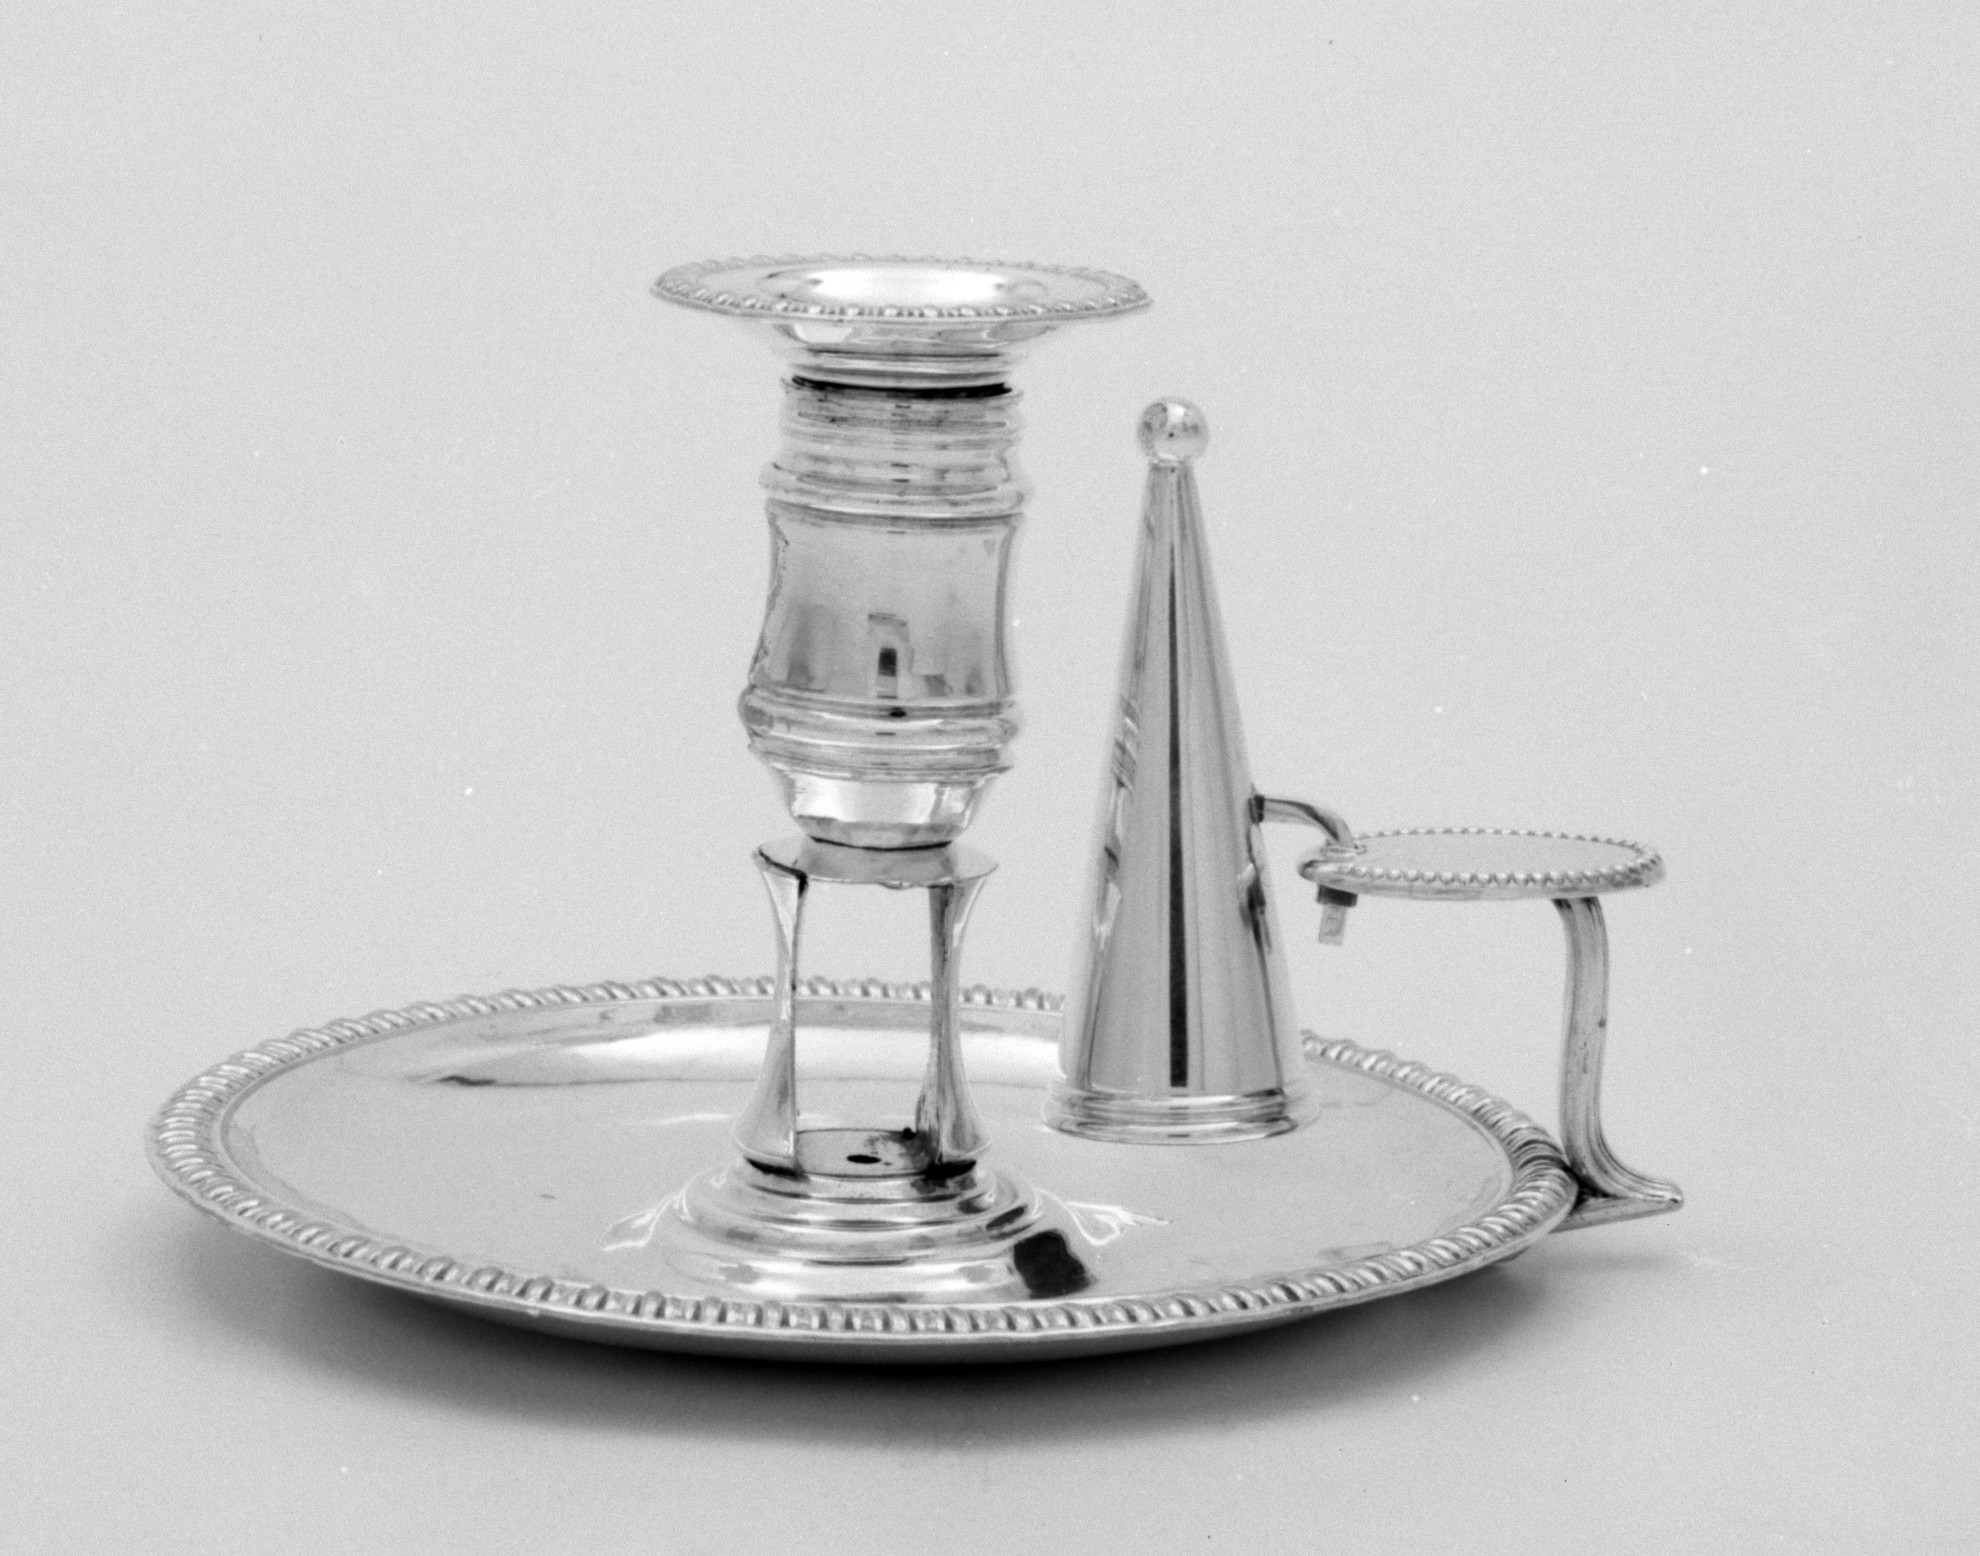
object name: chamber candlestick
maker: tudor and leader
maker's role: maker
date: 1760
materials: metal